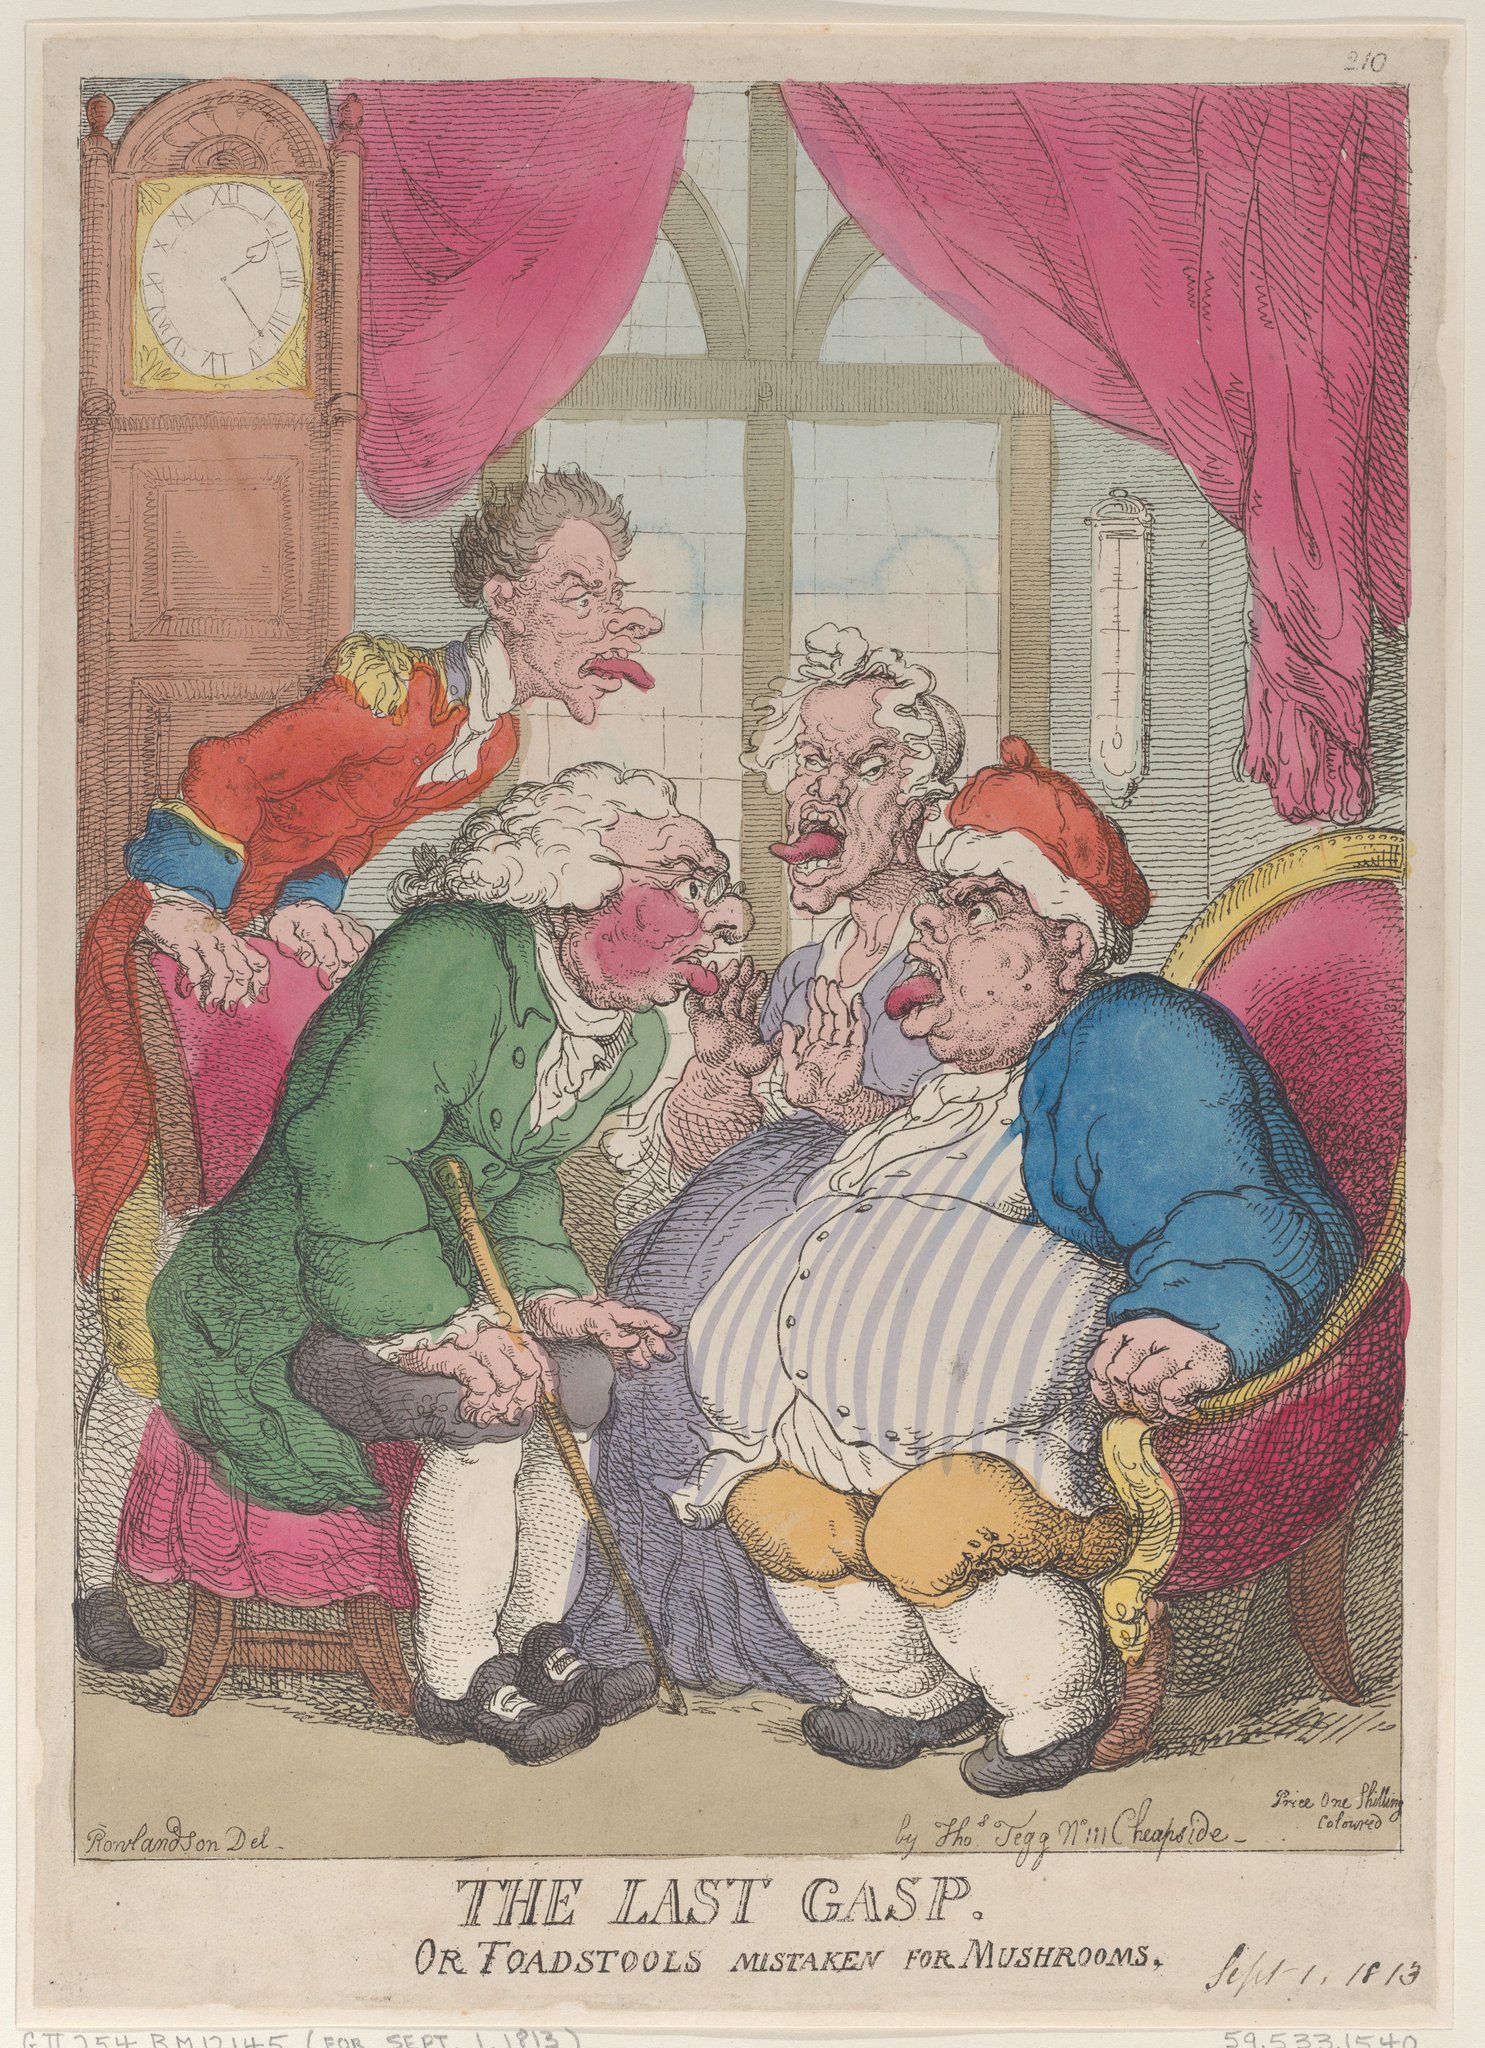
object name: print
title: The Last Gasp, or Toadstools Mistaken for Mushrooms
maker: thomas rowlandson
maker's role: artist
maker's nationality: british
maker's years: 1757-1827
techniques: etching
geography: london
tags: satire,men,women,doctors